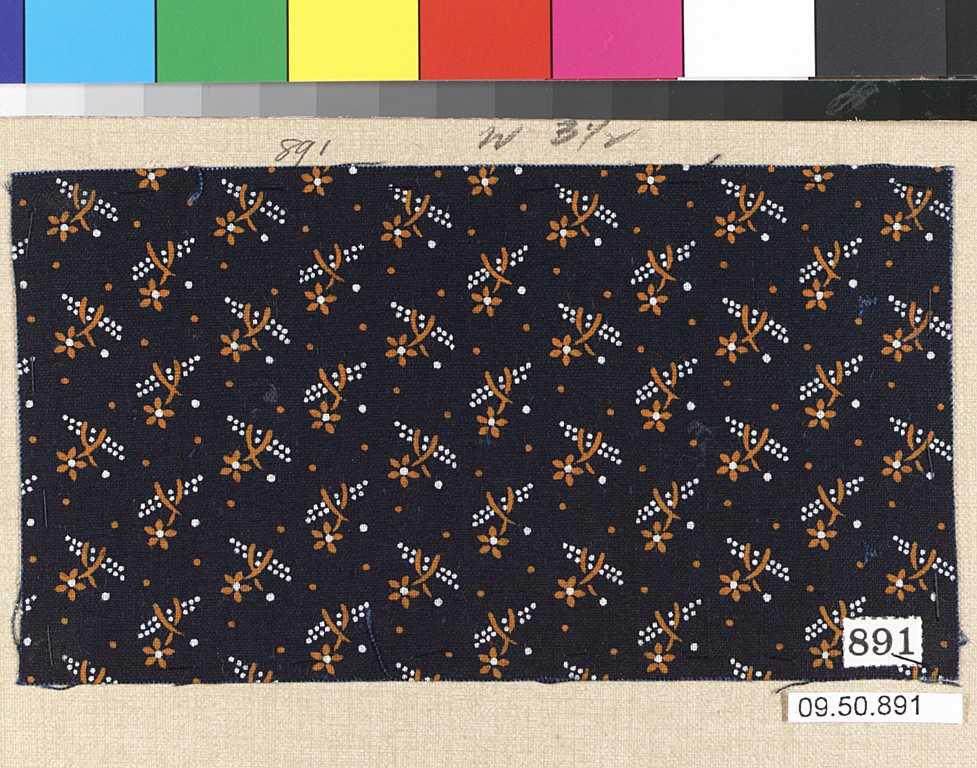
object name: piece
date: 1801-1900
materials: cotton